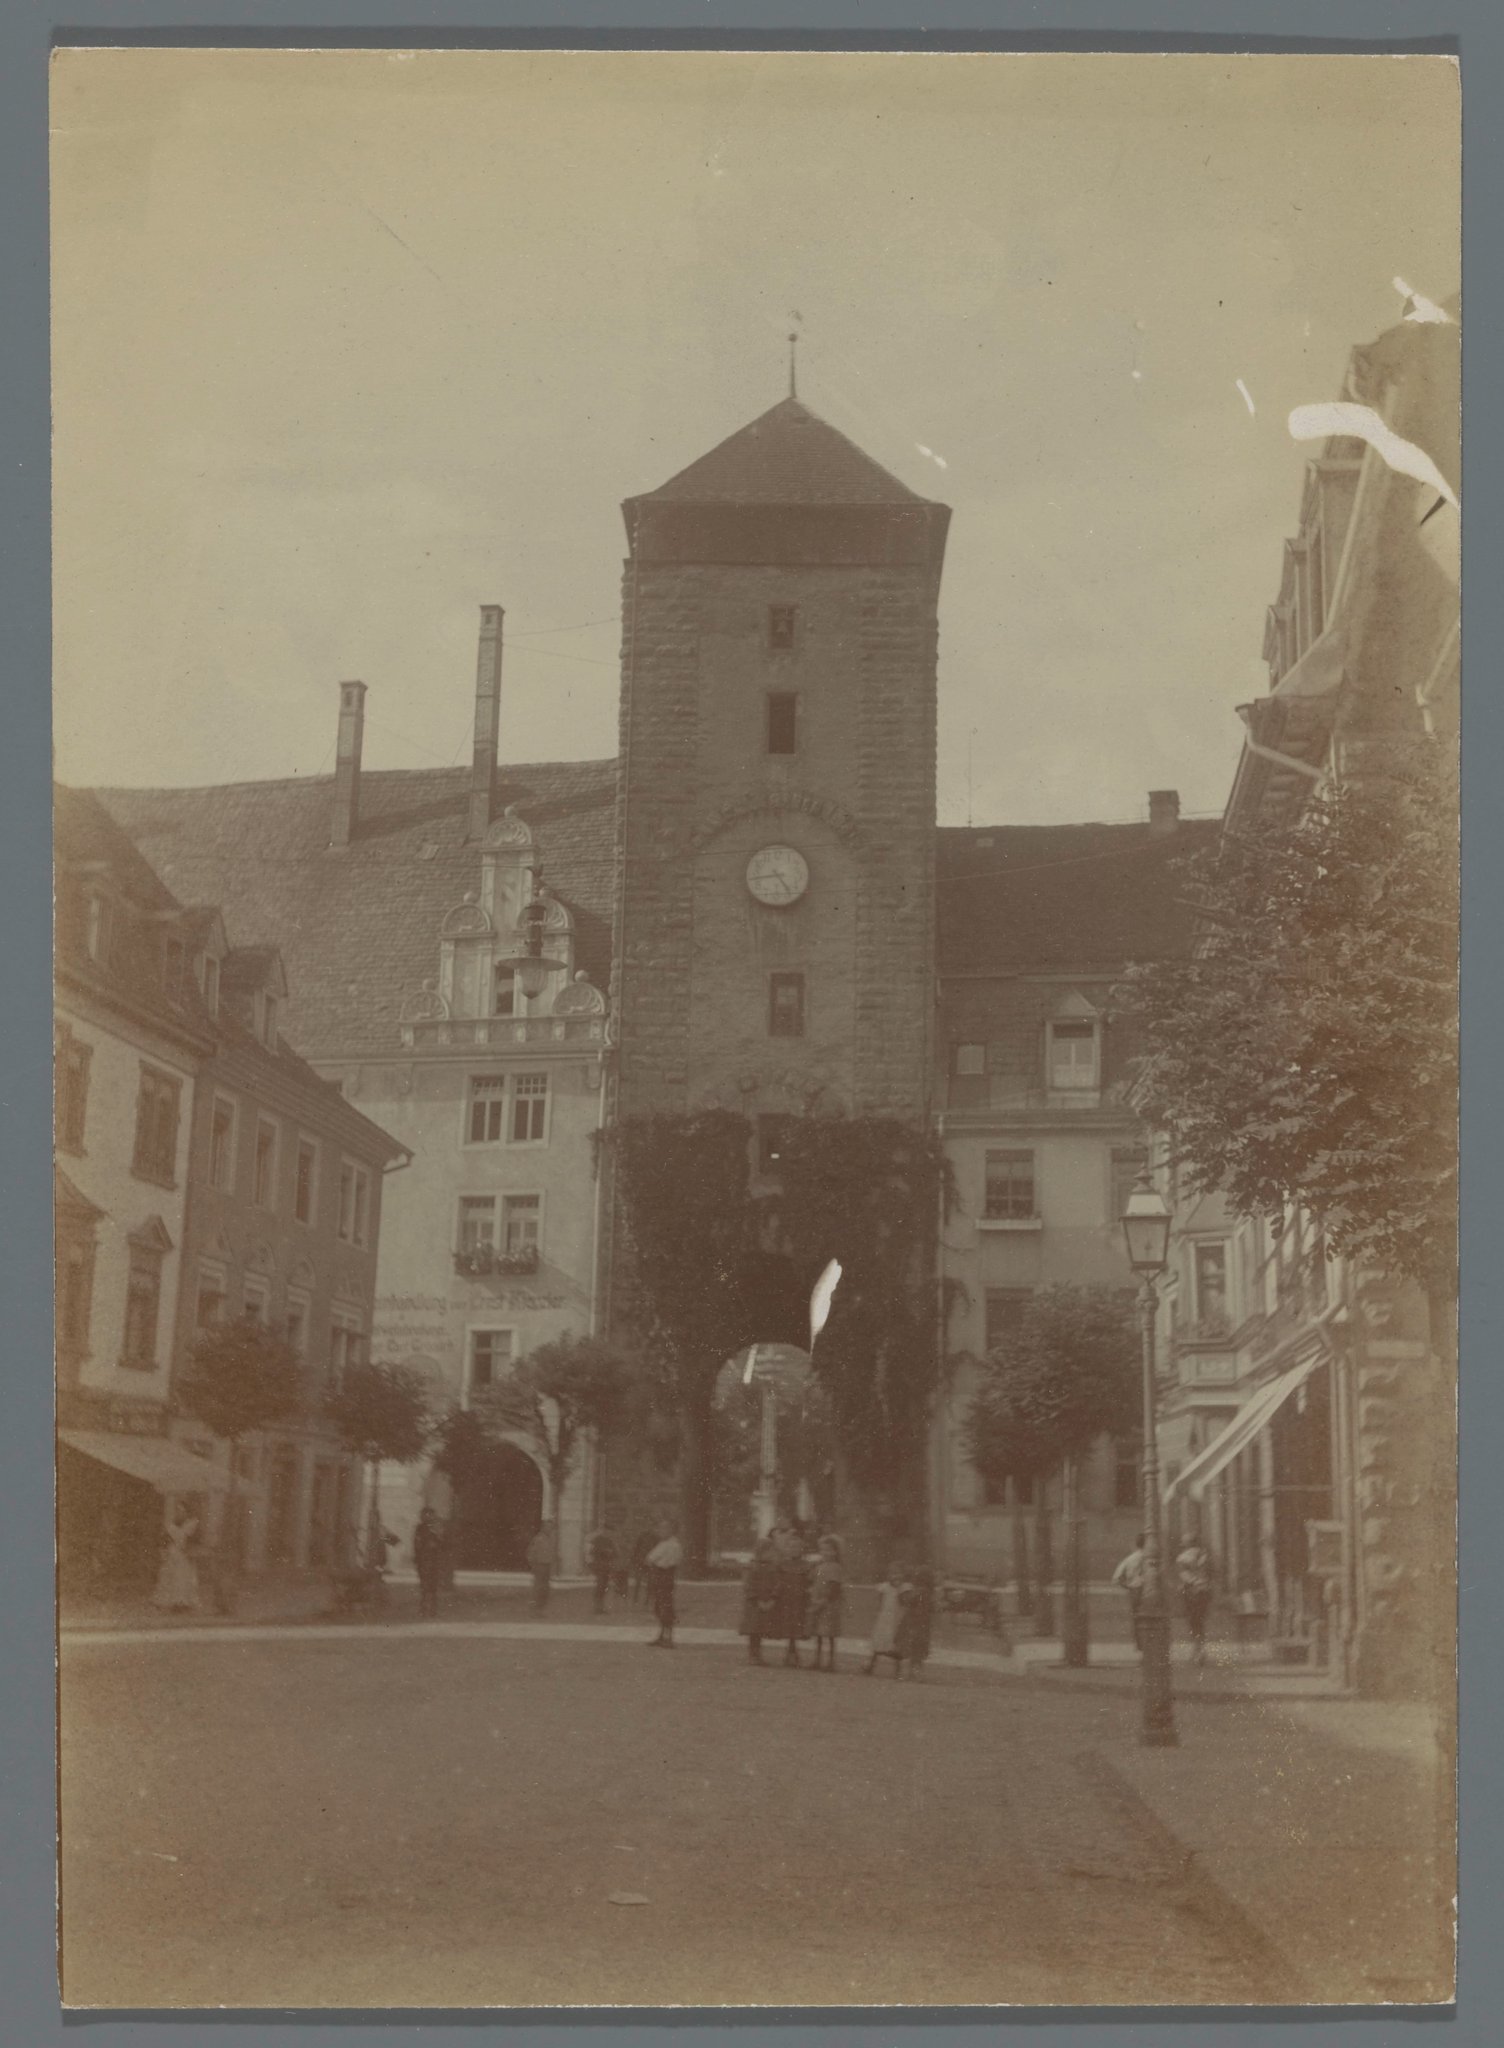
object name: photograph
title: Stadsgezicht met een klokkentoren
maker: cornelia hendrika jonker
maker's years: 1874-1924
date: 1880-1940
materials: photographic support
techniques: gelatin silver print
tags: tower, clock tower ~ monumental adornment, city-view in general; 'veduta'